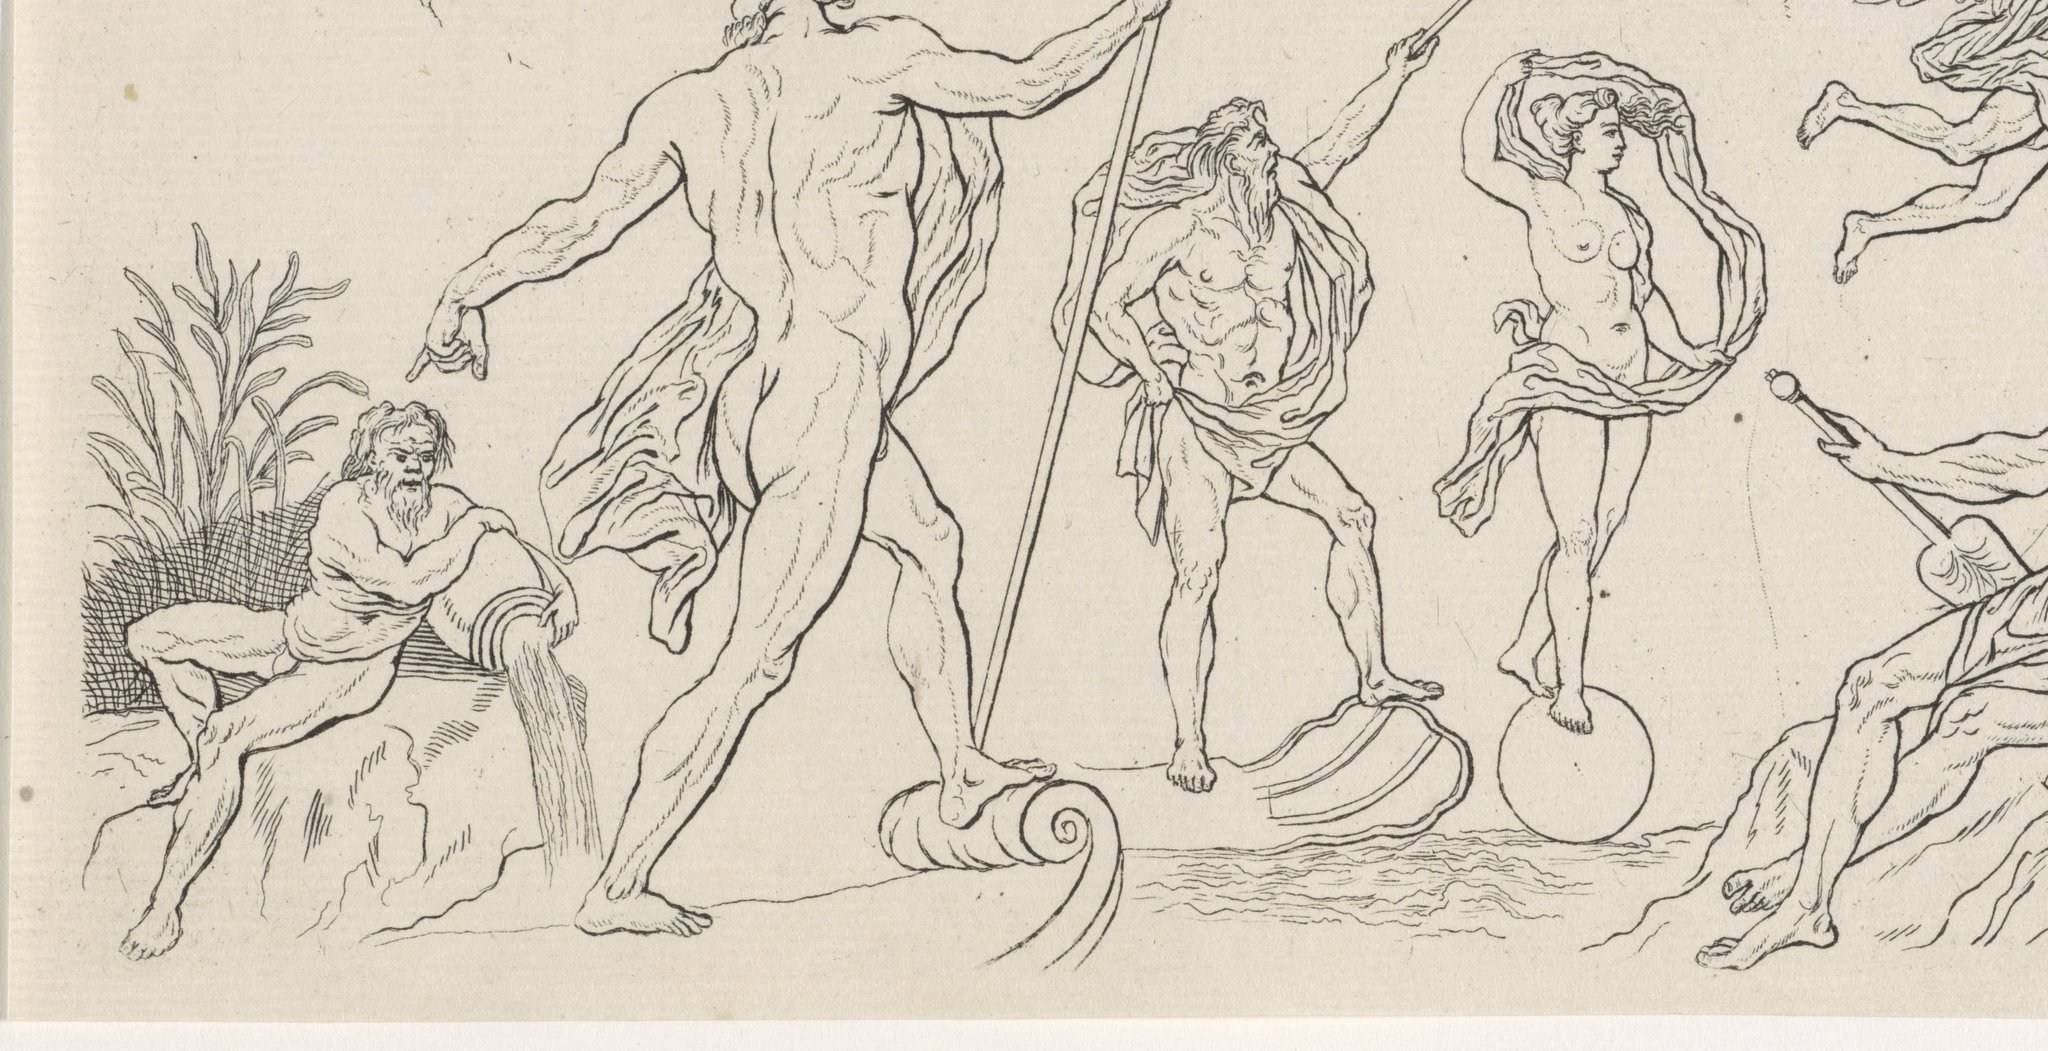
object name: print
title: Studies van verschillende zeegoden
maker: leonard schenk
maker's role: print maker, publisher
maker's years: 1696-1767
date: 1710-1767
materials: paper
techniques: etching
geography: amsterdam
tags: (story of) neptune (poseidon), river personified, 'fiumi' (ripa), river-gods, fortuna as roman personification, father time, man with wings and scythe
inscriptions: collector's mark: Lugt 2228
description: Studies van verschillende goden, voornamelijk zeegoden. Van links naar rechts: een stroomgod, achteraanzicht van Neptunus op een schelp met een drietand, vooraanzicht van Neptunus, Fortuna, Vadertje Tijd en uiterst rechts een tweede stroomgod. De prent is afkomstig uit een serie van vermoedelijk twaalf studievoorbeelden voor jonge kunstenaars.